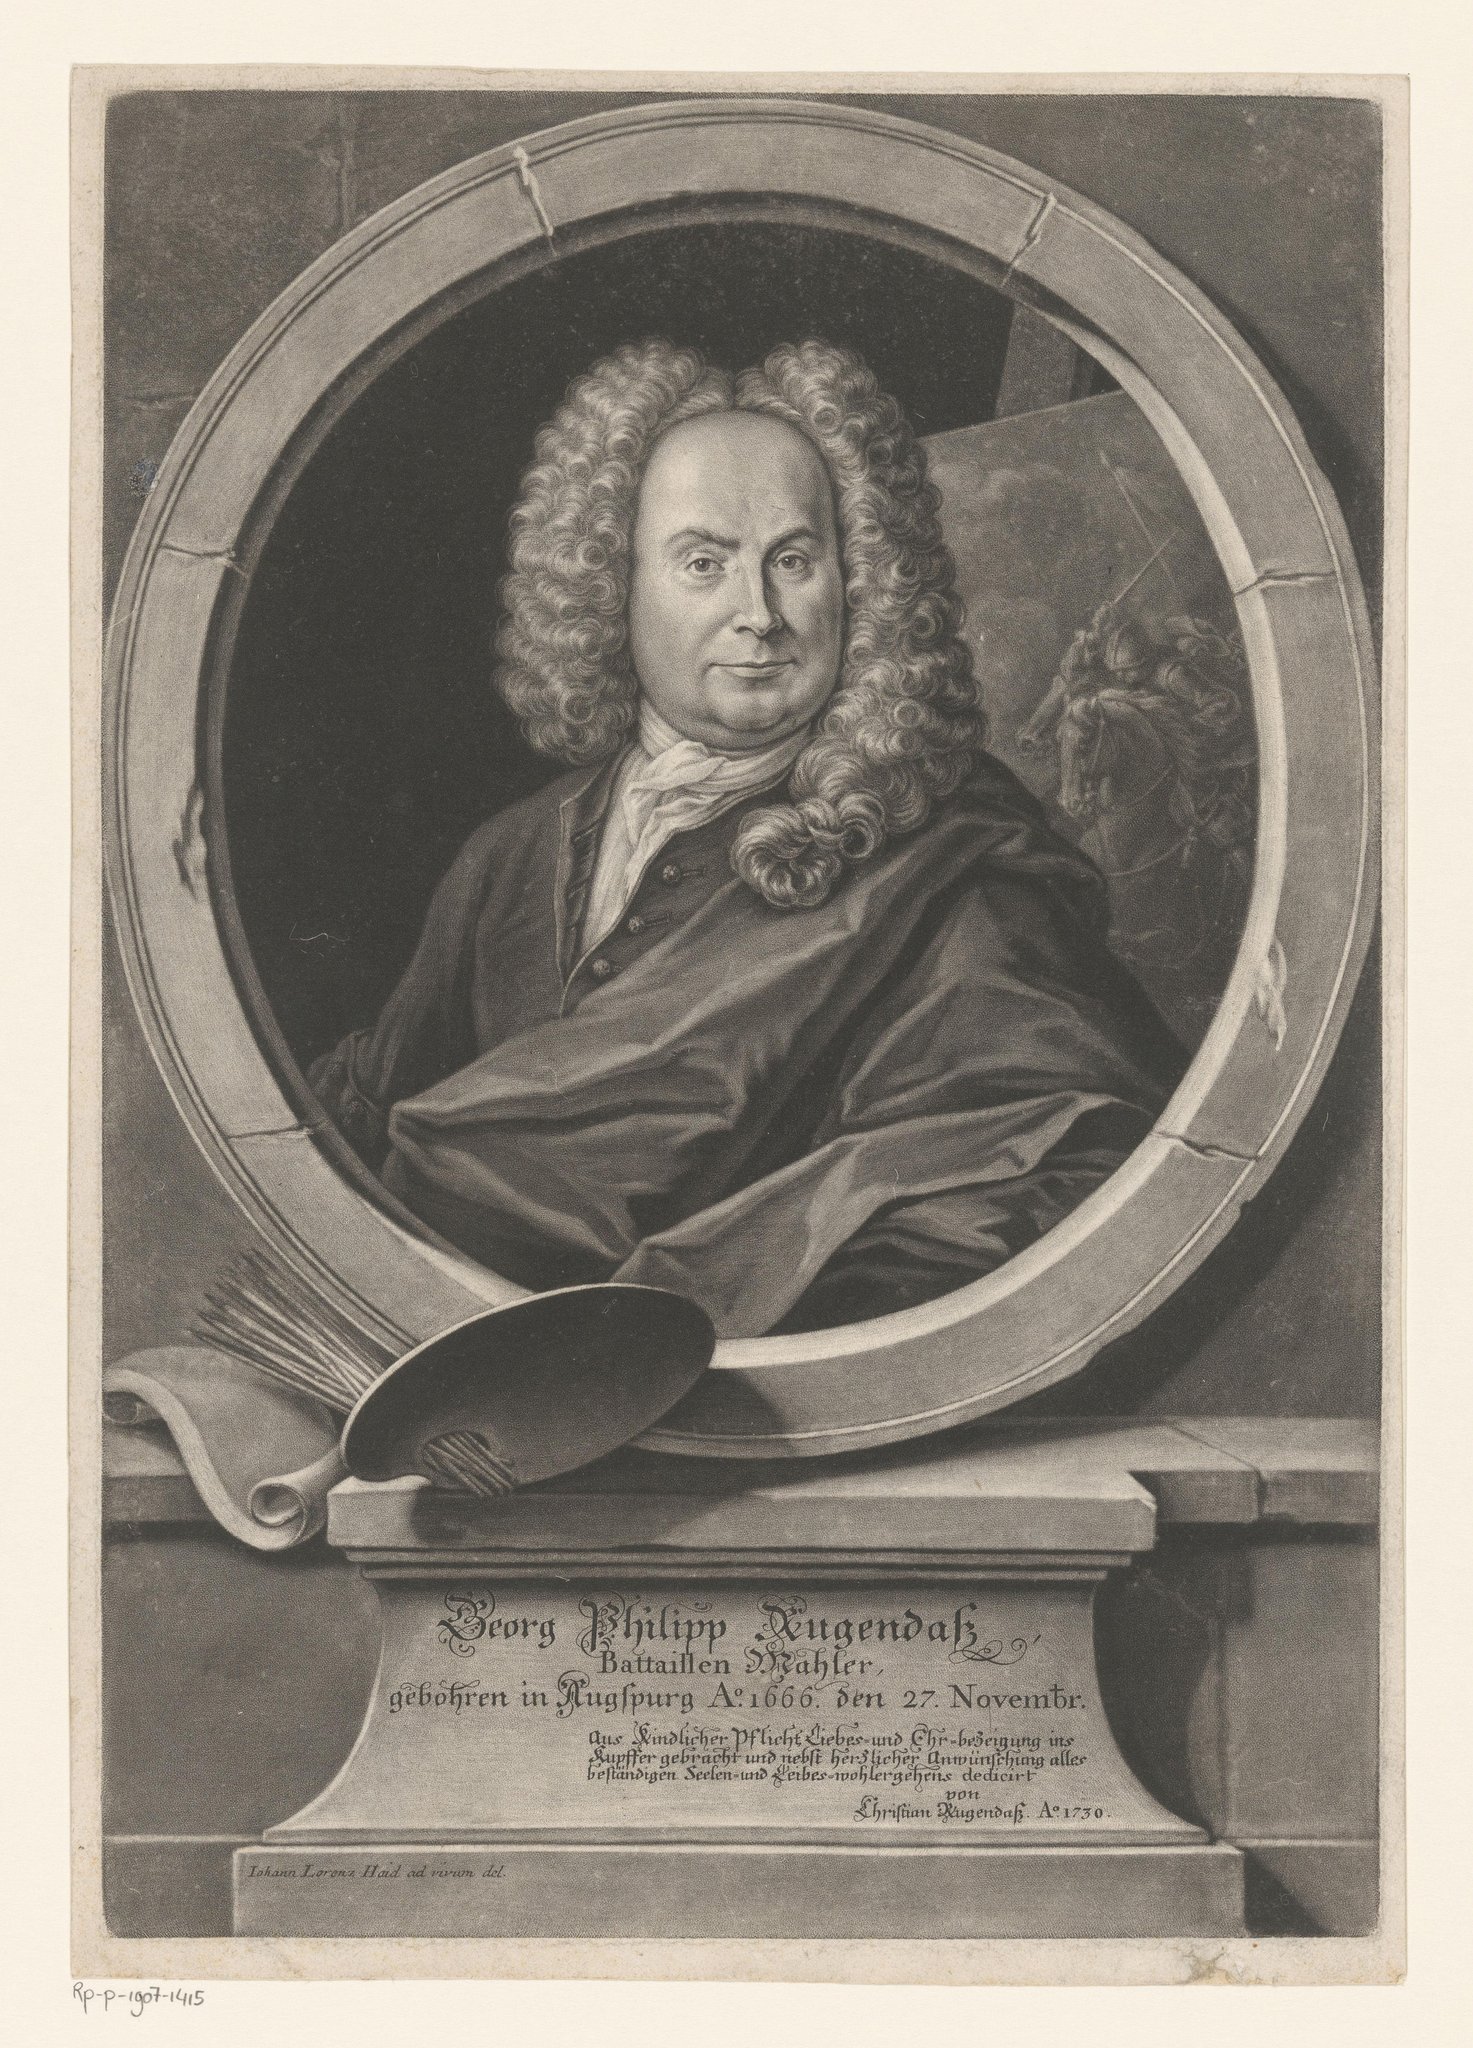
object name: print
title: Portret van Georg Philipp Rugendas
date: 1730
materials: paper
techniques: mezzotint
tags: augsburg, print maker, draughtsman, publisher, georg philipp rugendas (i), historical persons, tools, implements of painter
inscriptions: collector's mark: Lugt 2228